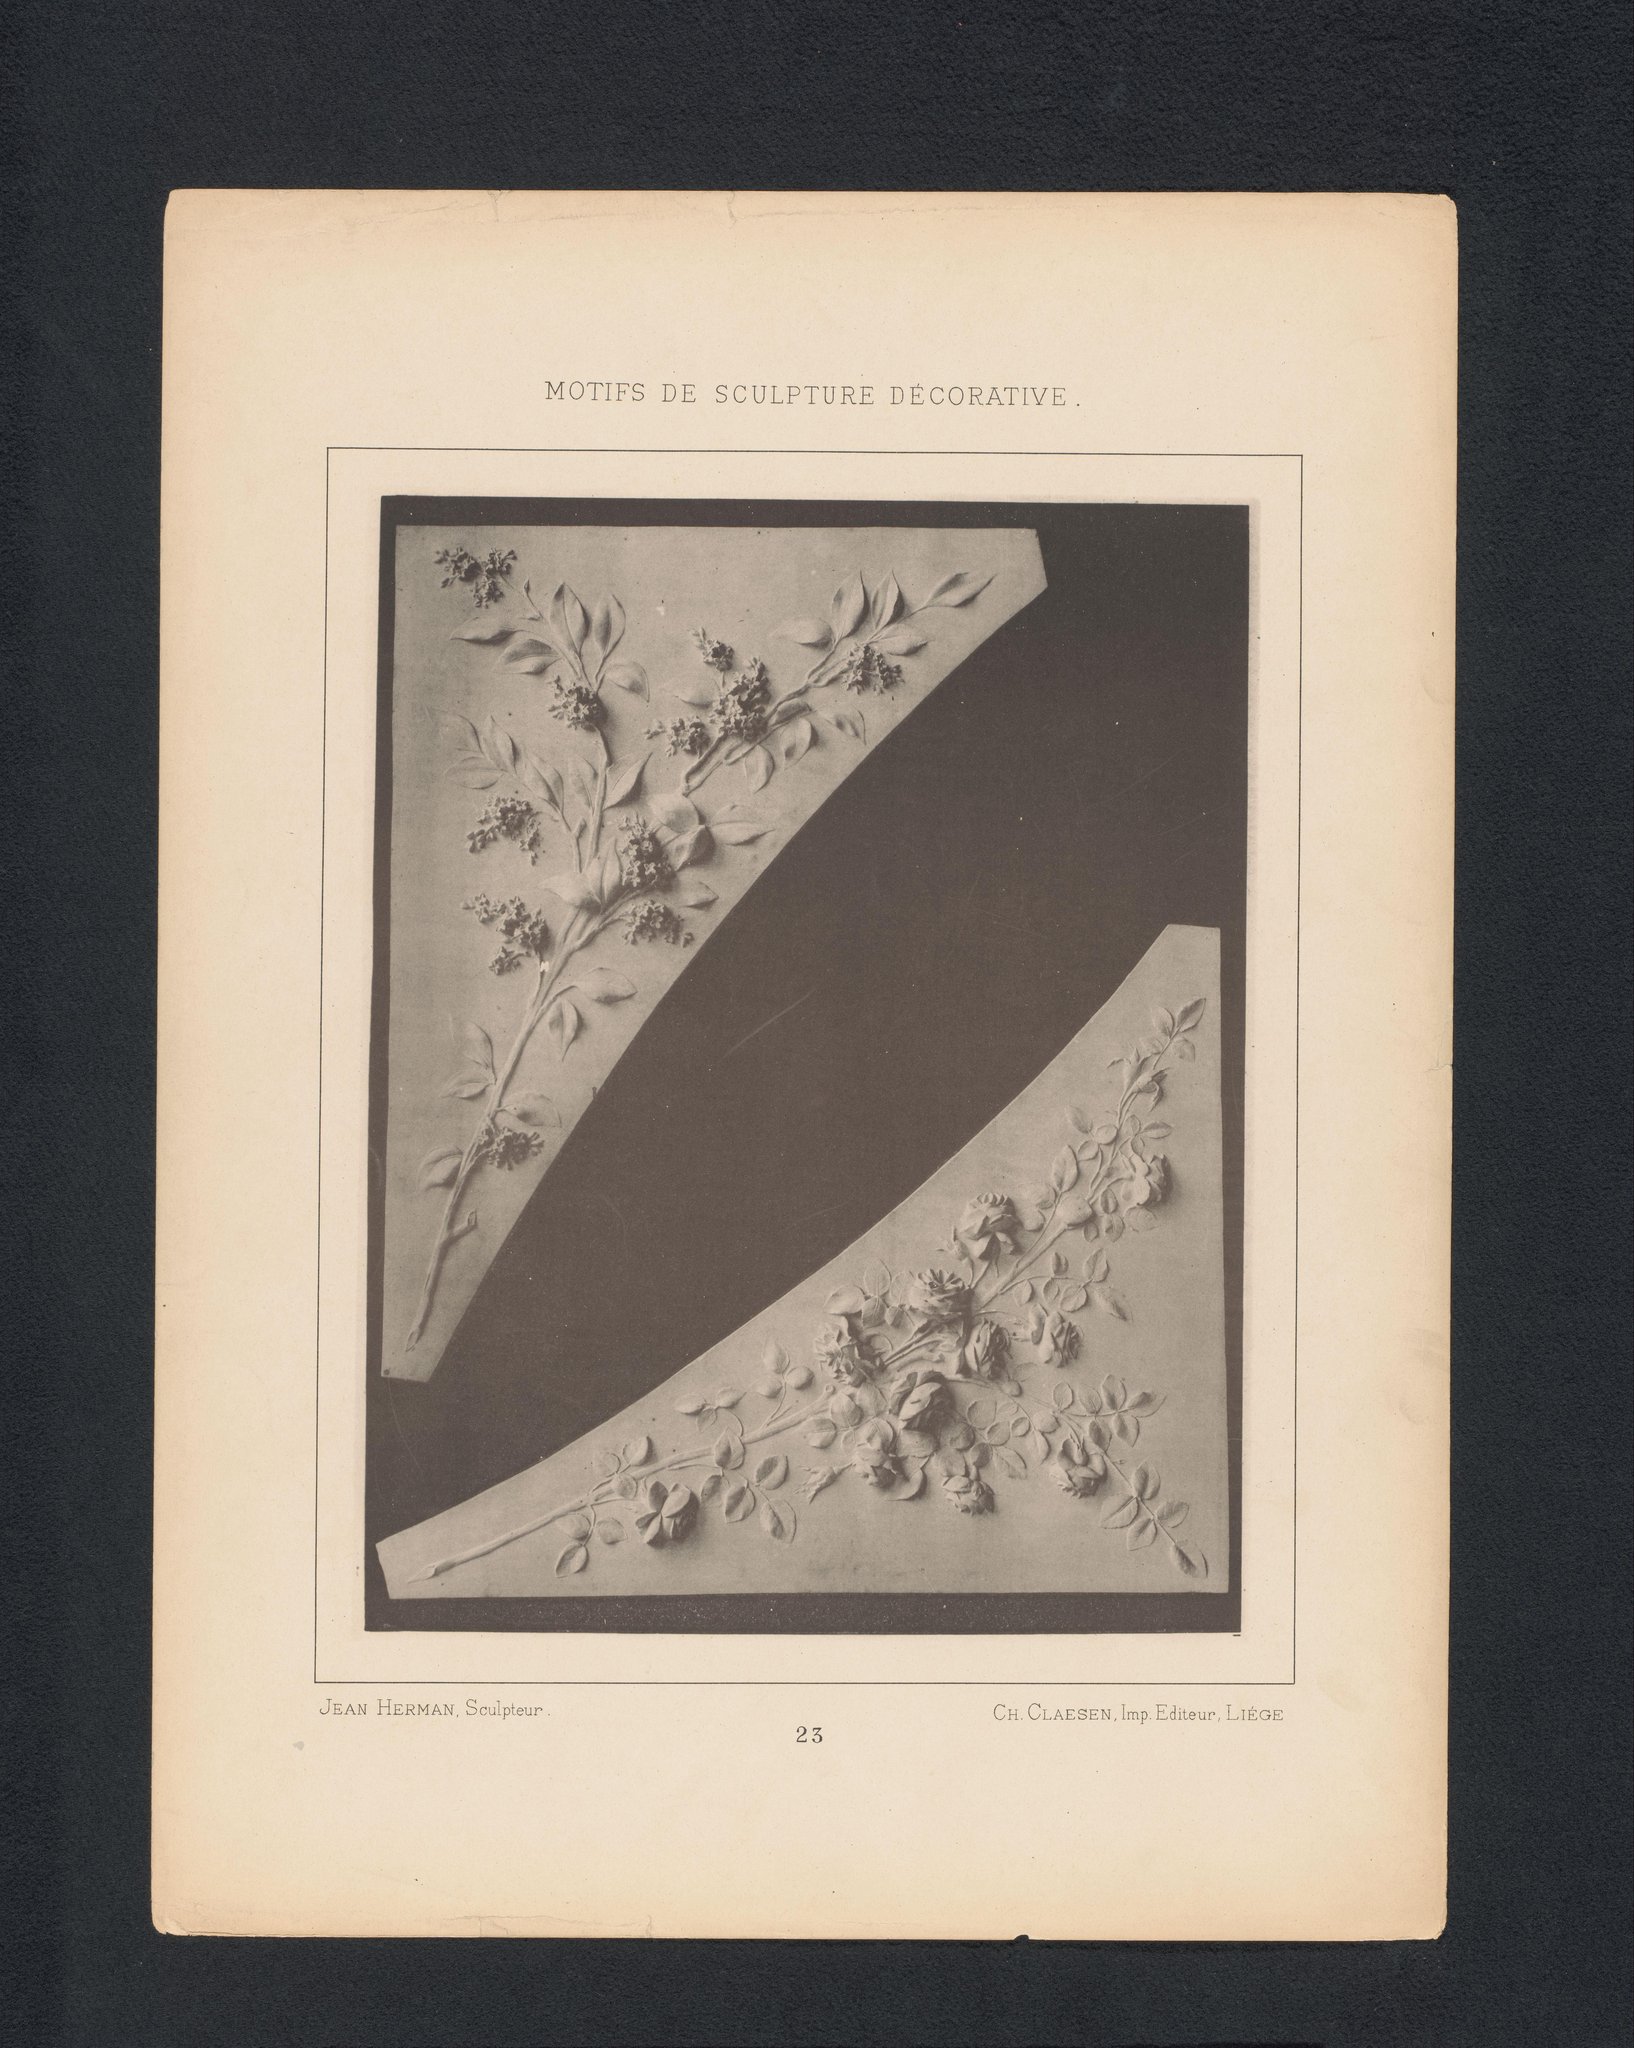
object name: photomechanical print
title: Twee reliëfs van een tak met bloemen, waaronder één roos, gebeeldhouwd door Jean Herman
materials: paper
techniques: photograph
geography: liège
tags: branches, 'astwerk' ~ ornament, flowers ~ ornament, sculpture (+ relief ~ sculpture)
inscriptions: number: ‘23’, inscription: ‘Jean Herman, Sculpteur.’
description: Deze prent maakt deel uit van een omslag met 28 prenten en een titelblad.